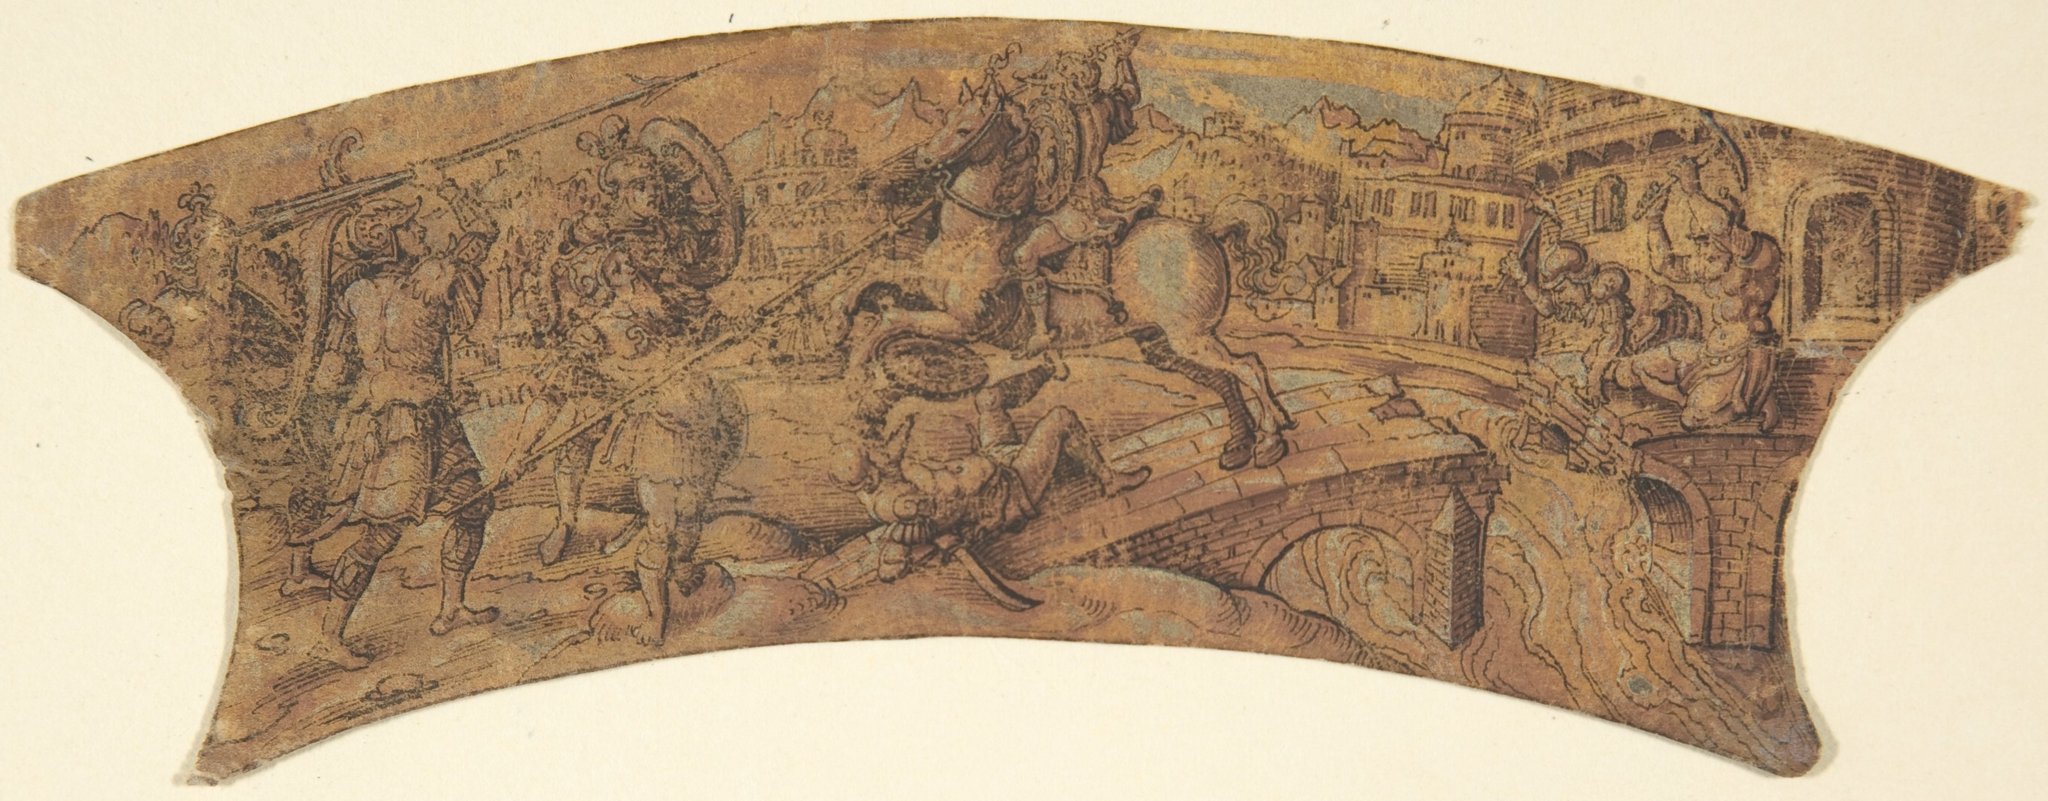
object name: drawing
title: Design for Border of a Shield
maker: anonymous, german, 19th century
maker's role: artist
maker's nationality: german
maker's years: 1800-1899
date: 1801-1900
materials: gouache, ink, paper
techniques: brush, pen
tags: battles,soldiers,shields,weapons,horses